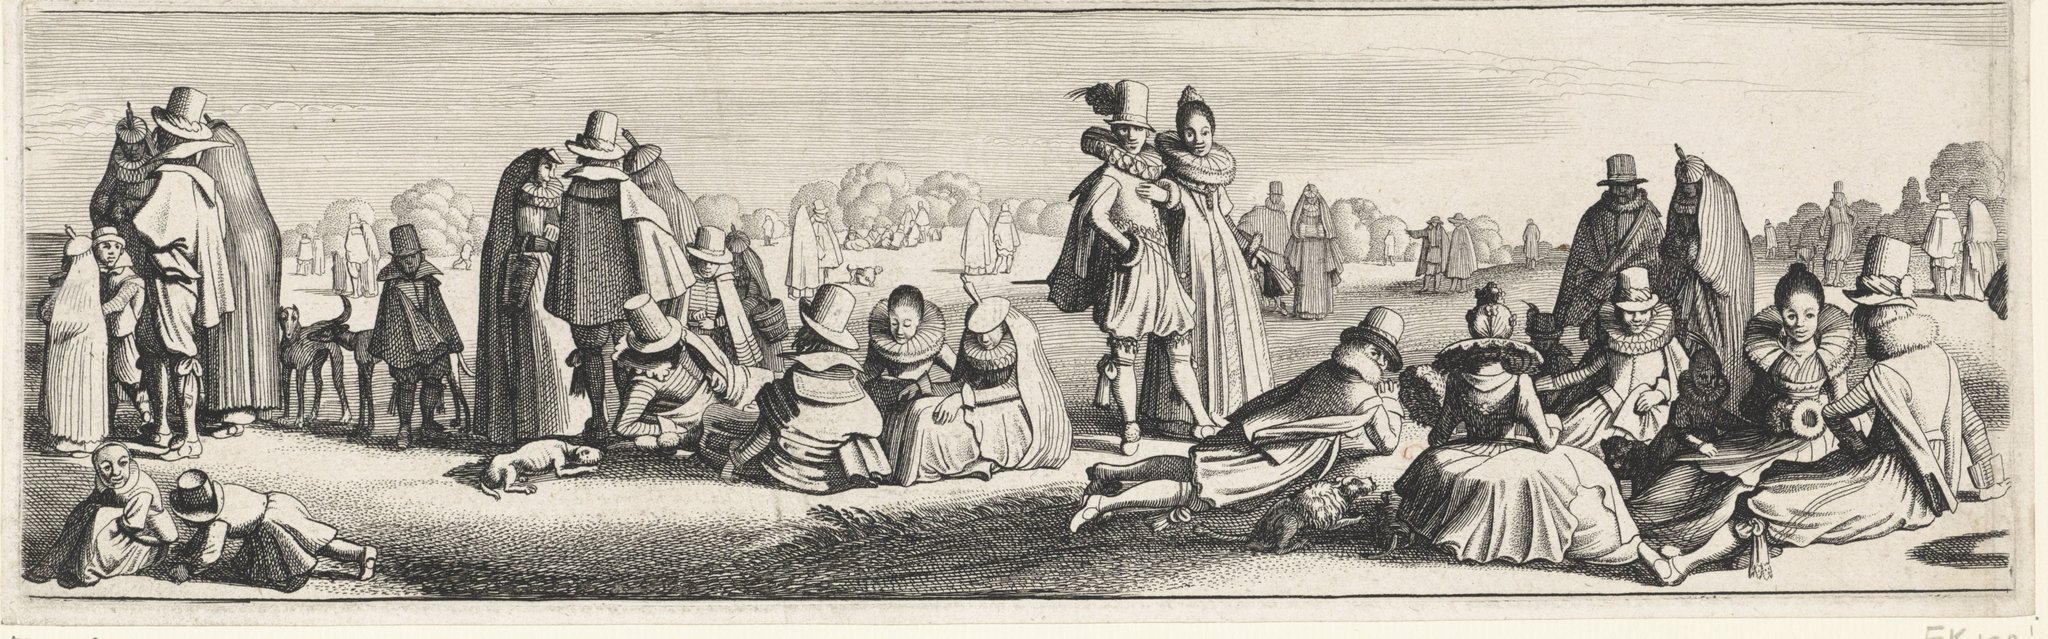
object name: print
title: Wandelende en zittende elegante paren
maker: jan van de velde (ii)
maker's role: draughtsman, painter, print maker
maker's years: 1593-1641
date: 1603-1641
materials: paper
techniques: engraving, etching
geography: northern netherlands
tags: walking, hiking (recreation), cape (huik) (+ women's clothes), clothes, costume (+ women's clothes), clothes, costume (+ men's clothes), open-air recreation, market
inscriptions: collector's mark: Lugt 240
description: Rechts en in het midden op de voorgrond een elegant gezelschap, zittend op het gras, omringd door elegant geklede paren en groepjes pratende figuren en spelende kinderen. Derde prent van een fries bestaande uit vier prenten, voorstellende een markt.